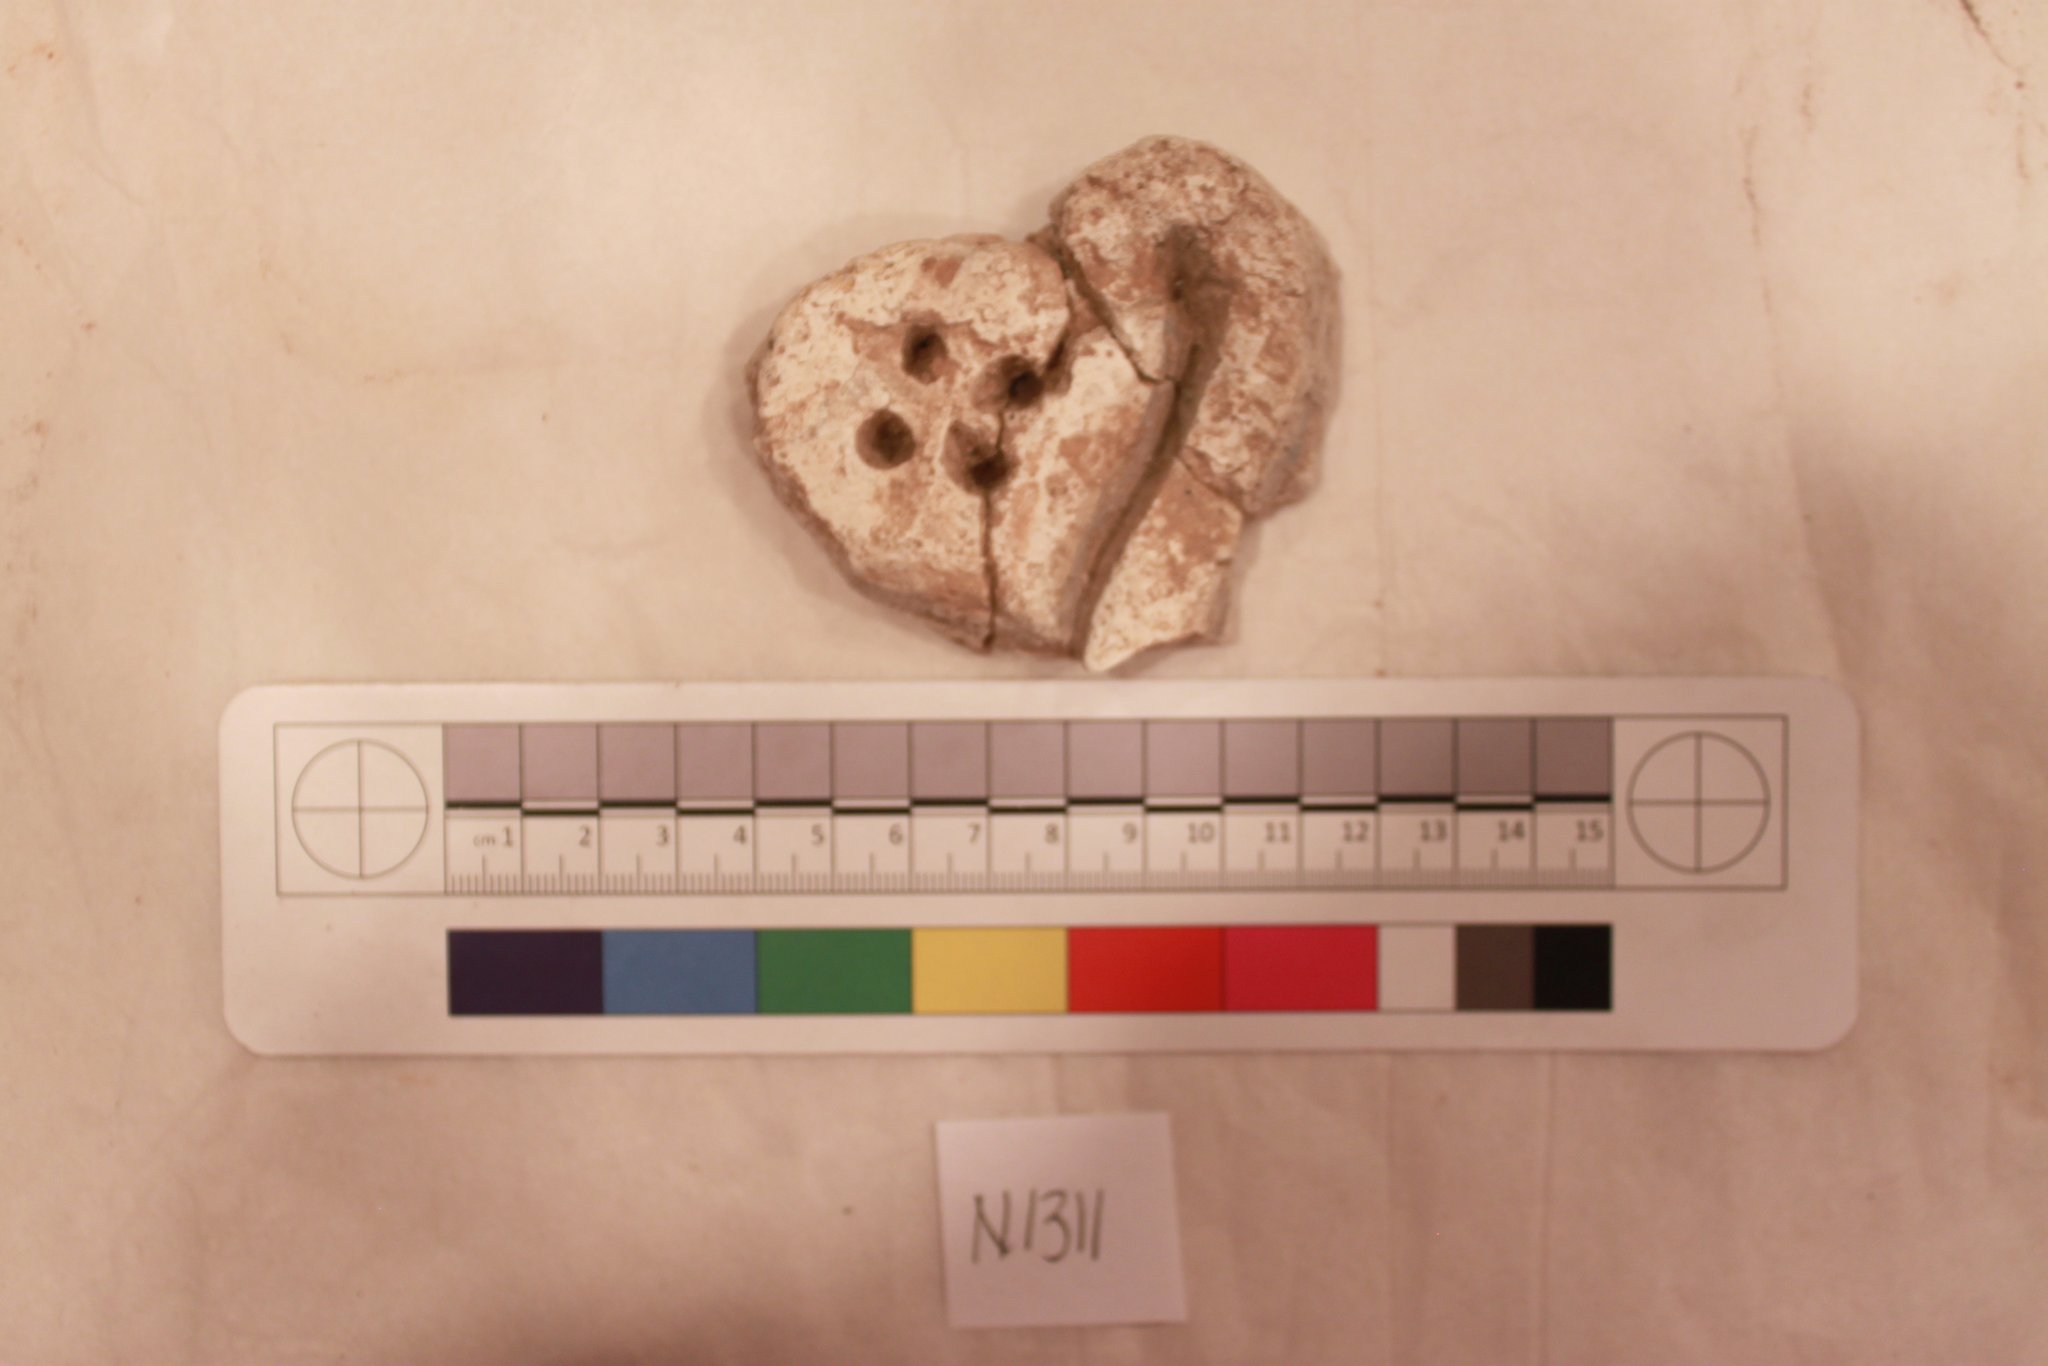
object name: fragment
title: Stucco Fragment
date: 701-1200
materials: plaster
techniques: carving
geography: iran